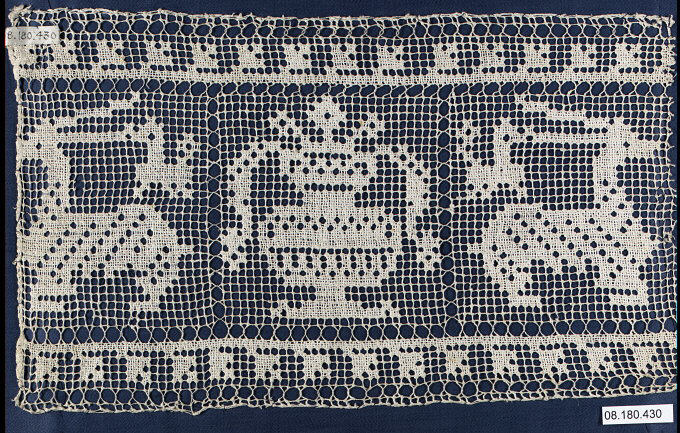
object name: border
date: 1501-1600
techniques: embroidery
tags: animals